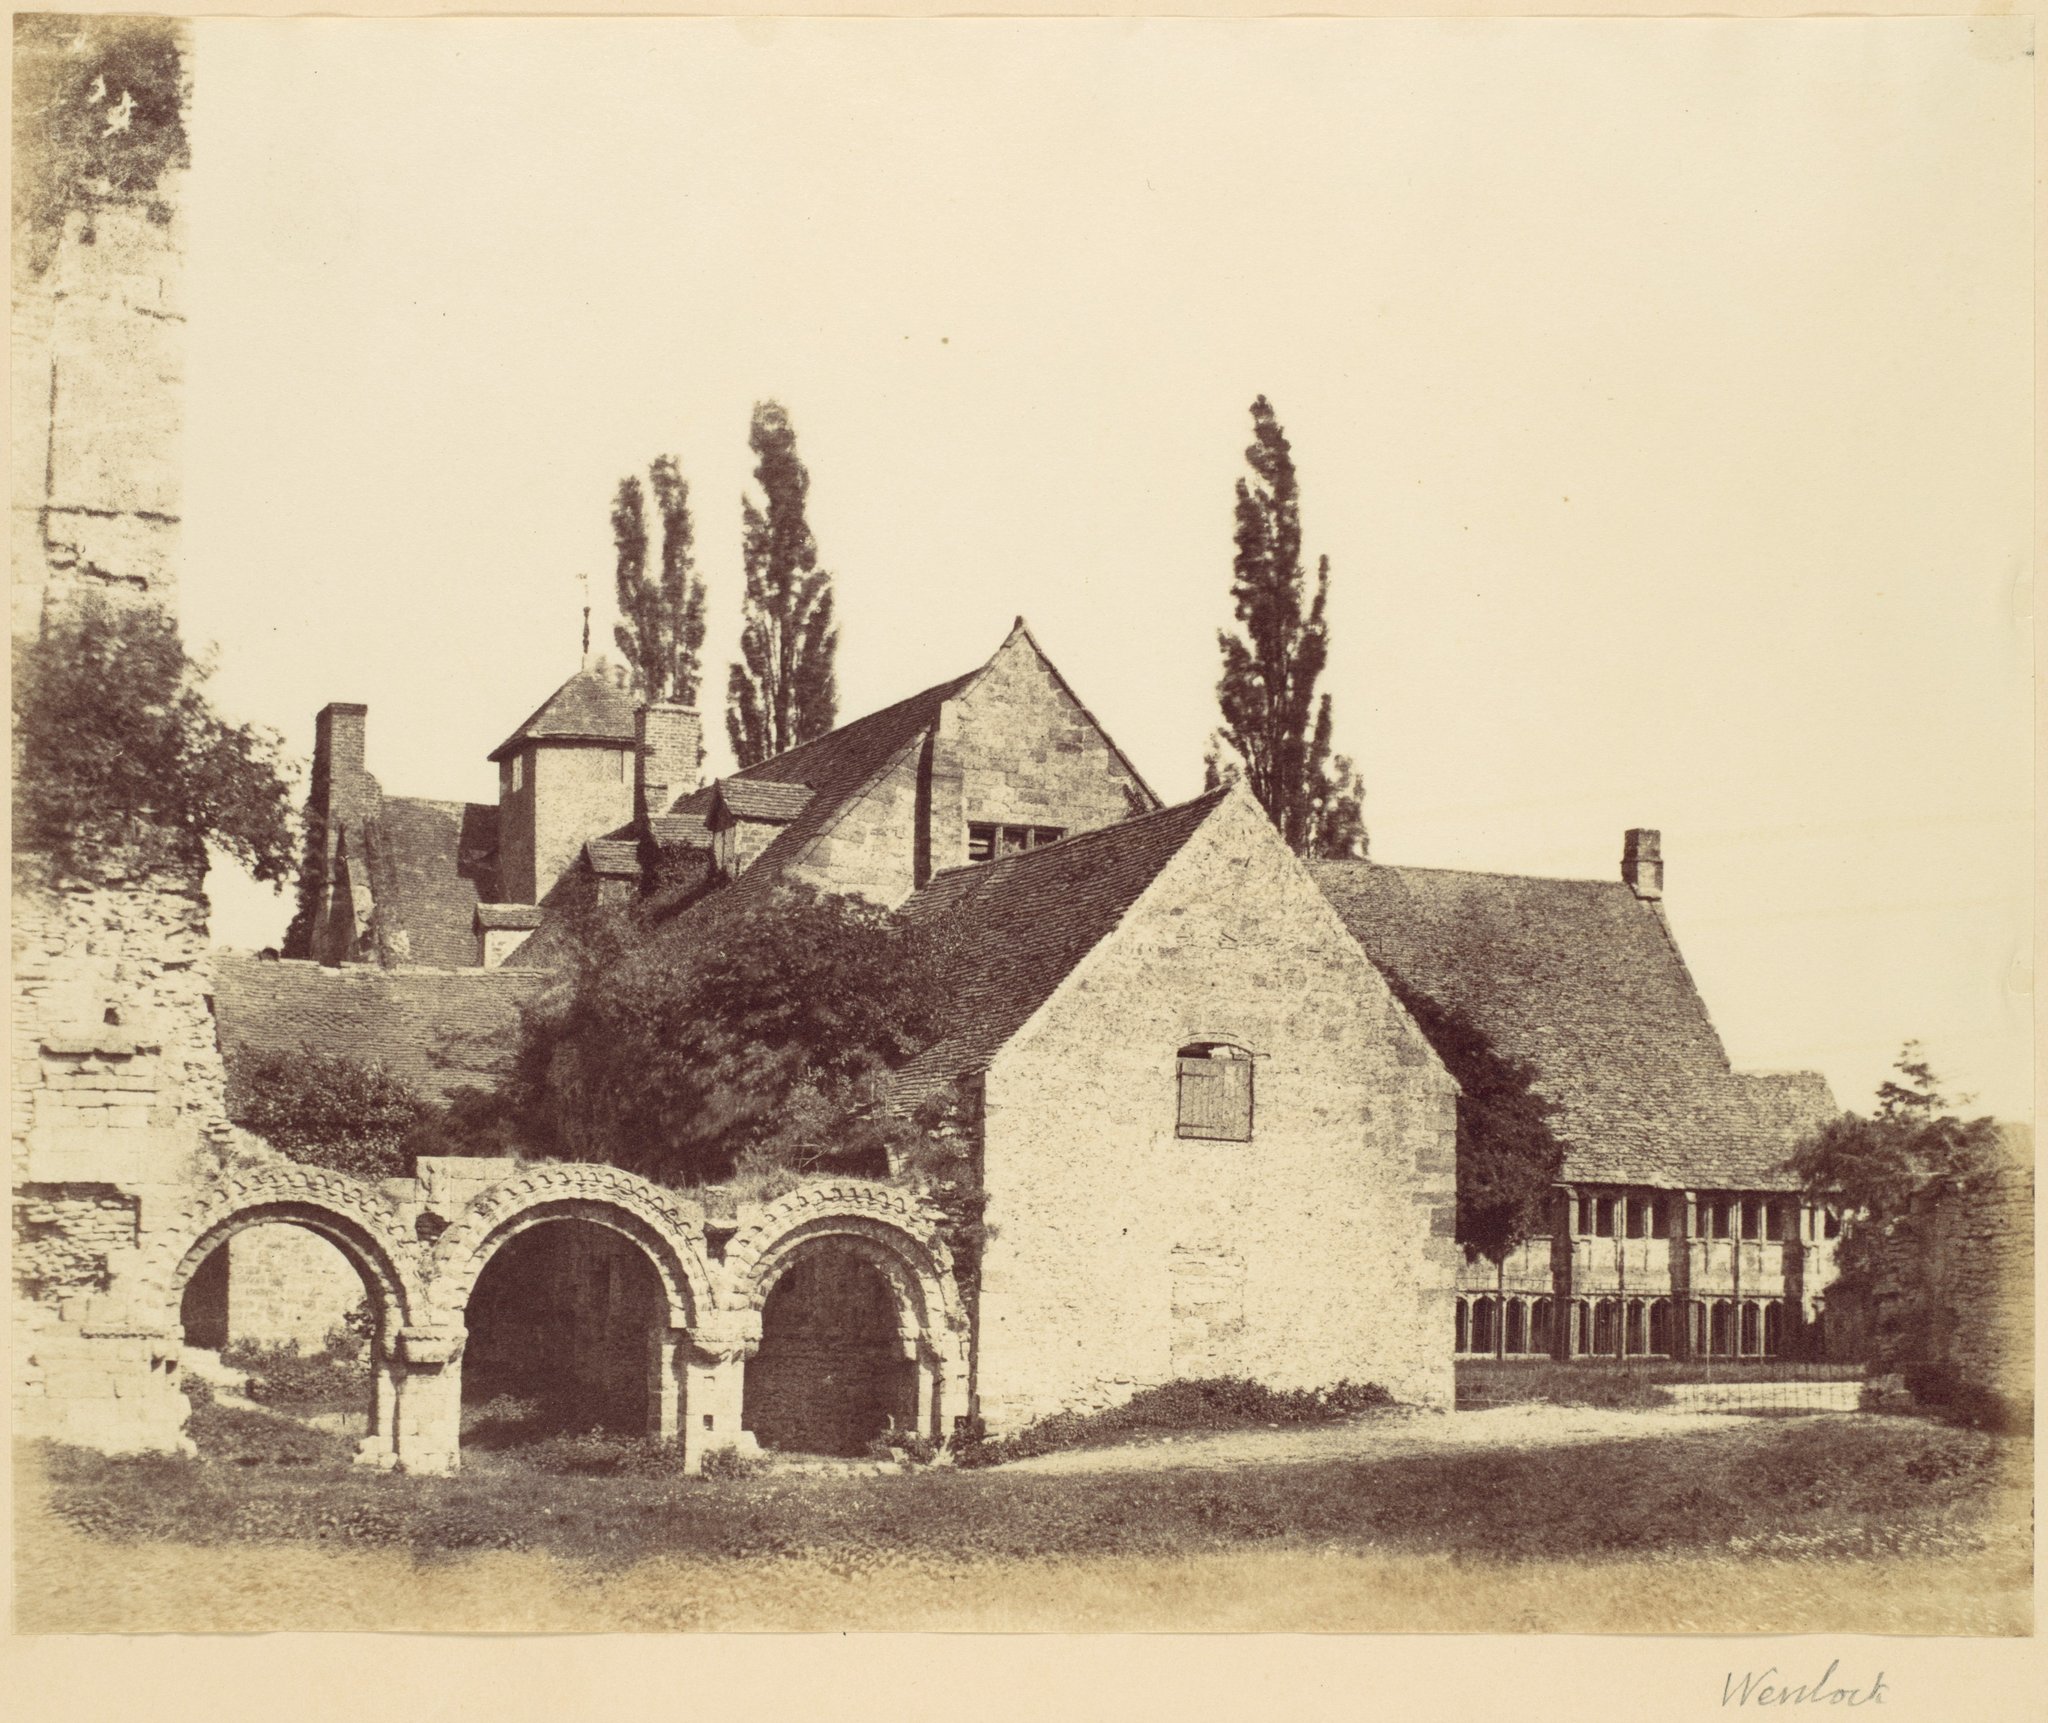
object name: photograph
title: Wenlock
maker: alfred capel cure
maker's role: artist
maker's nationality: british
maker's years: 1826-1896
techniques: albumen silver print, paper negative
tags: architecture